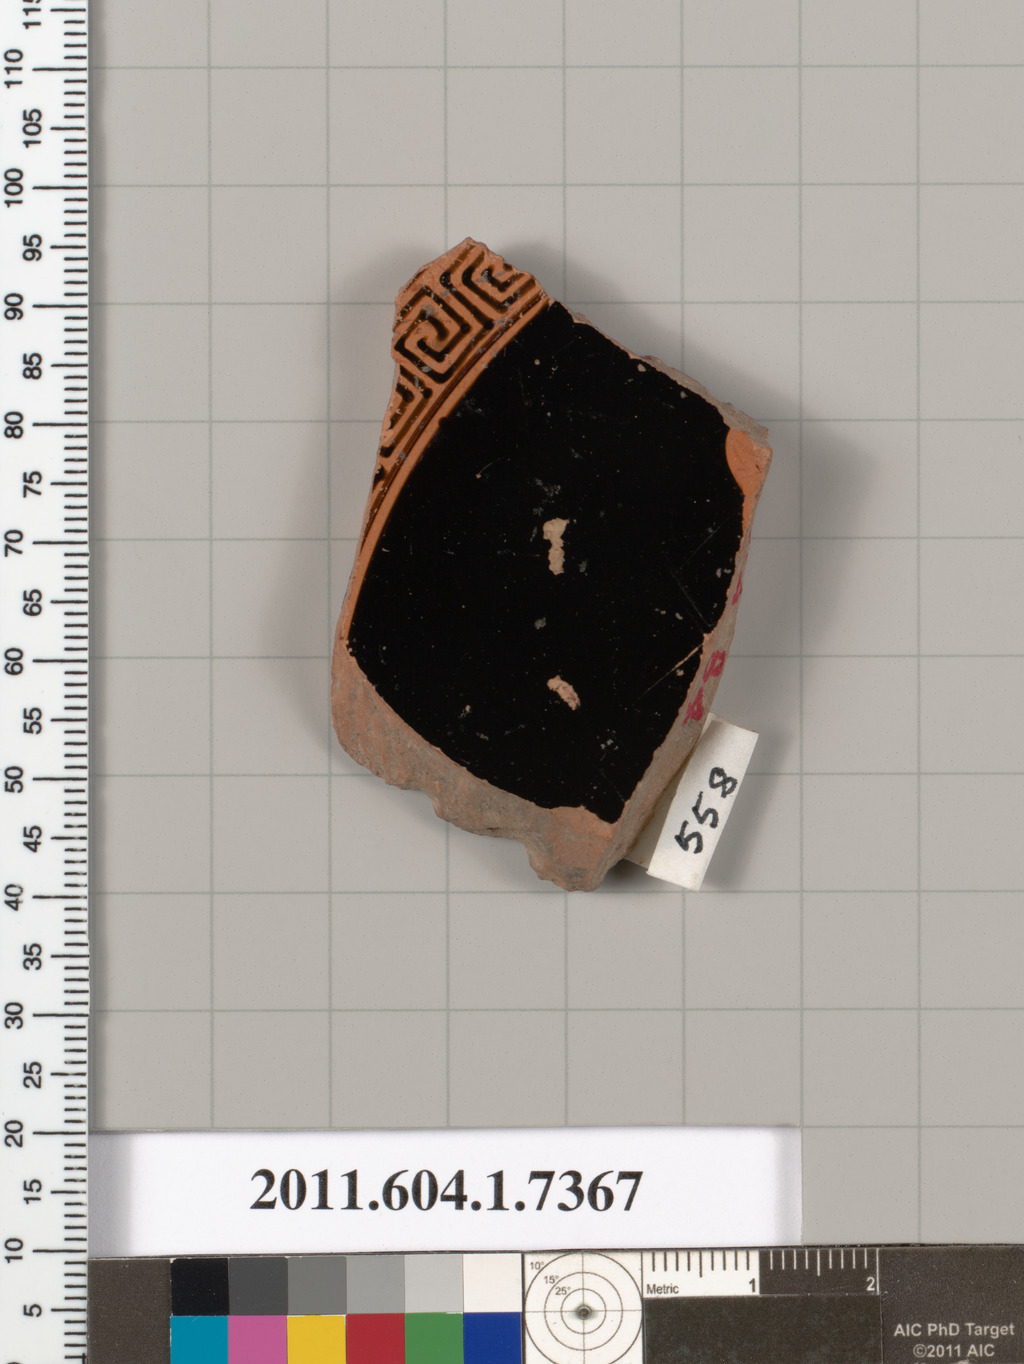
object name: kylix fragment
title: Terracotta fragment of a kylix (drinking cup)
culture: greek, attic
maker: makron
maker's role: artist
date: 500-480 BCE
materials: terracotta